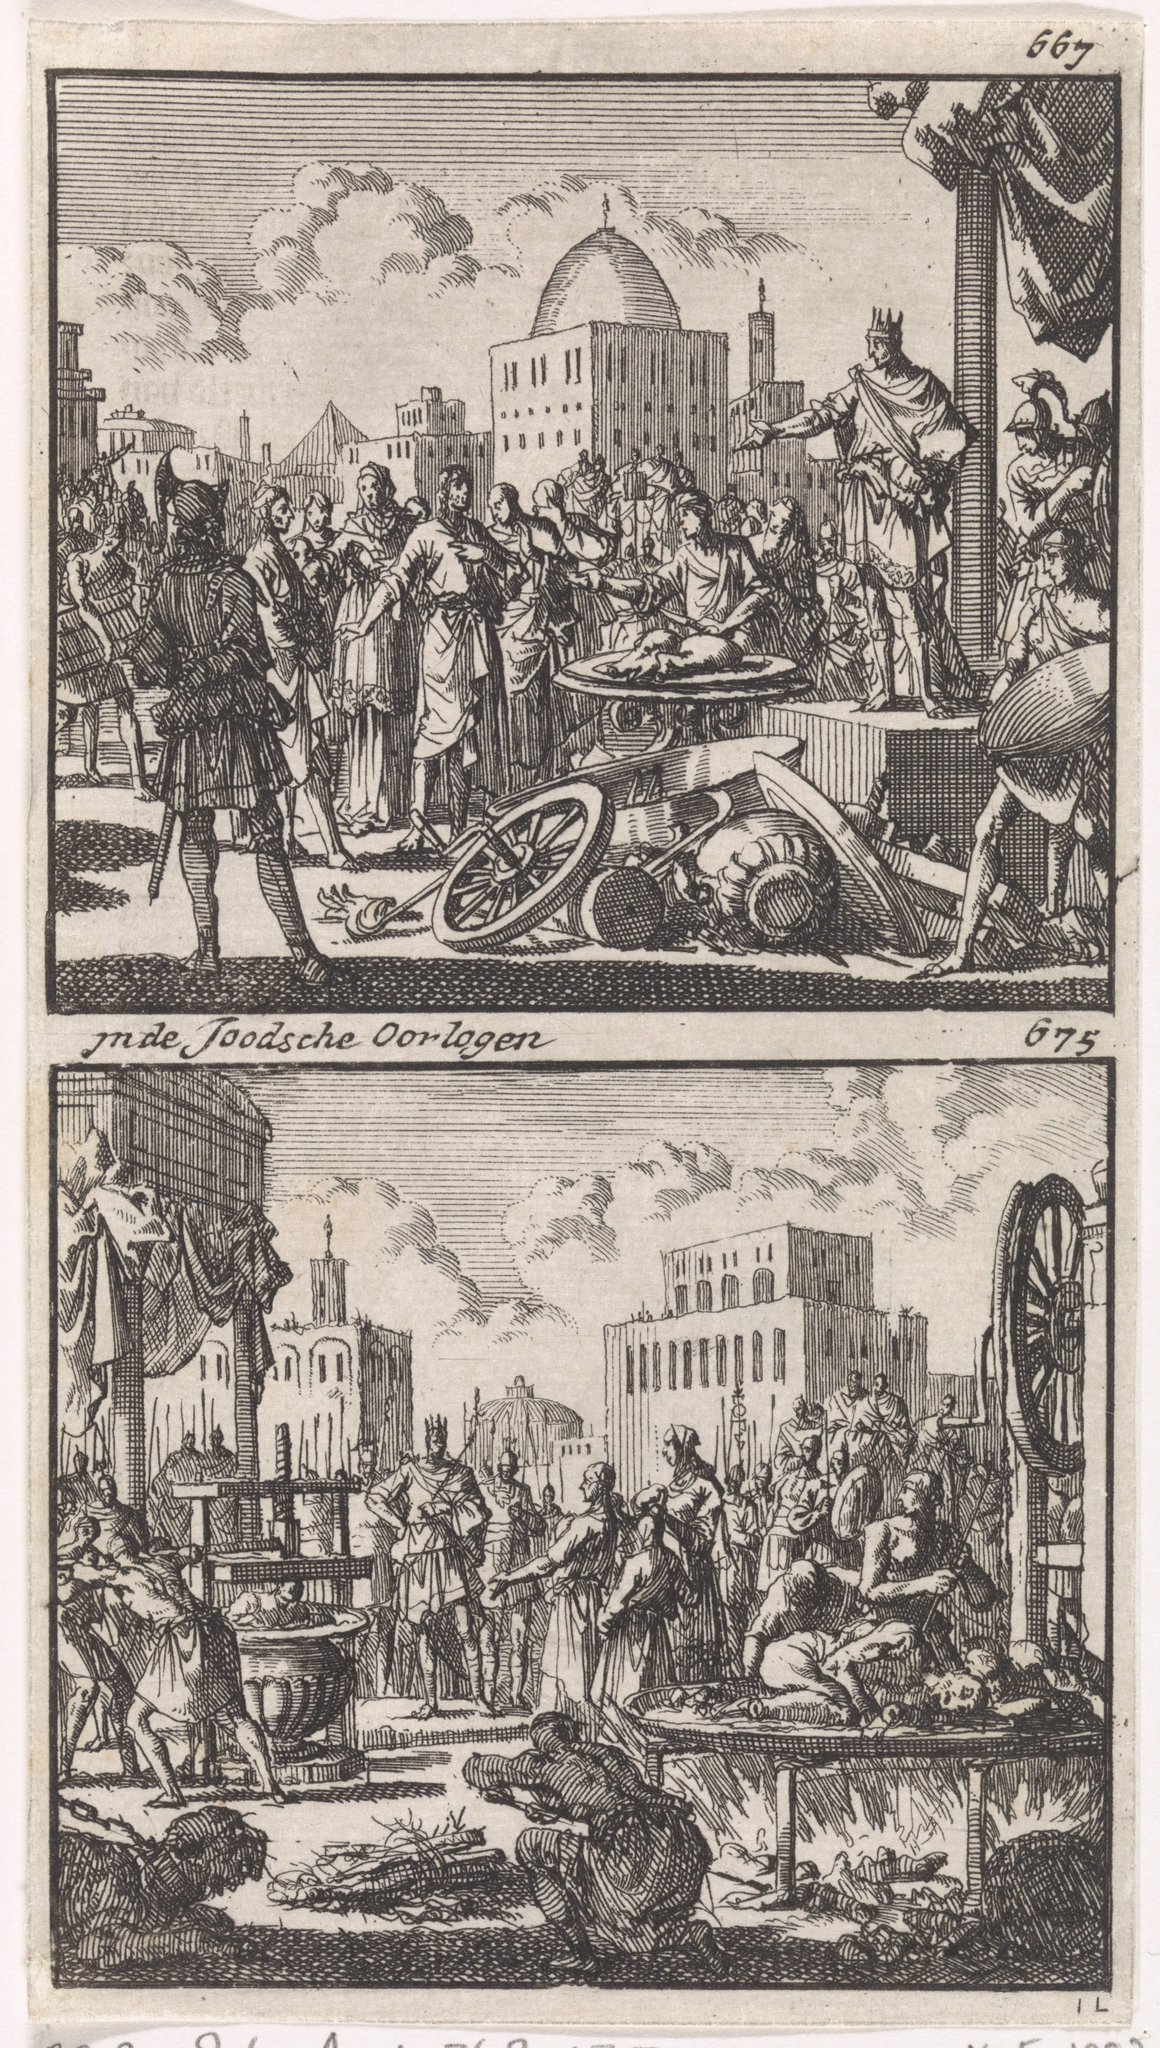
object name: book illustration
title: Antiochus Epiphanes probeert een moeder en zeven zonen over te halen om zwijnenvlees te eten / Dood van zeven zonen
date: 1698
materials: paper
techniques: etching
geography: amsterdam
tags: the martyrdom of the seven maccabean brothers and their mother under antiochus iv epiphanes (2 maccabees 7)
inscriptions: collector's mark: Lugt 2228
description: Illustratie uit: Josephus, Flavius. XX. boeken van de oude geschiedenissen der joden, 4 delen. Amsterdam: Barent Visscher, Willem de Coup, Willem van Lamsveld, Andries van Damme, 1698, dl. III.